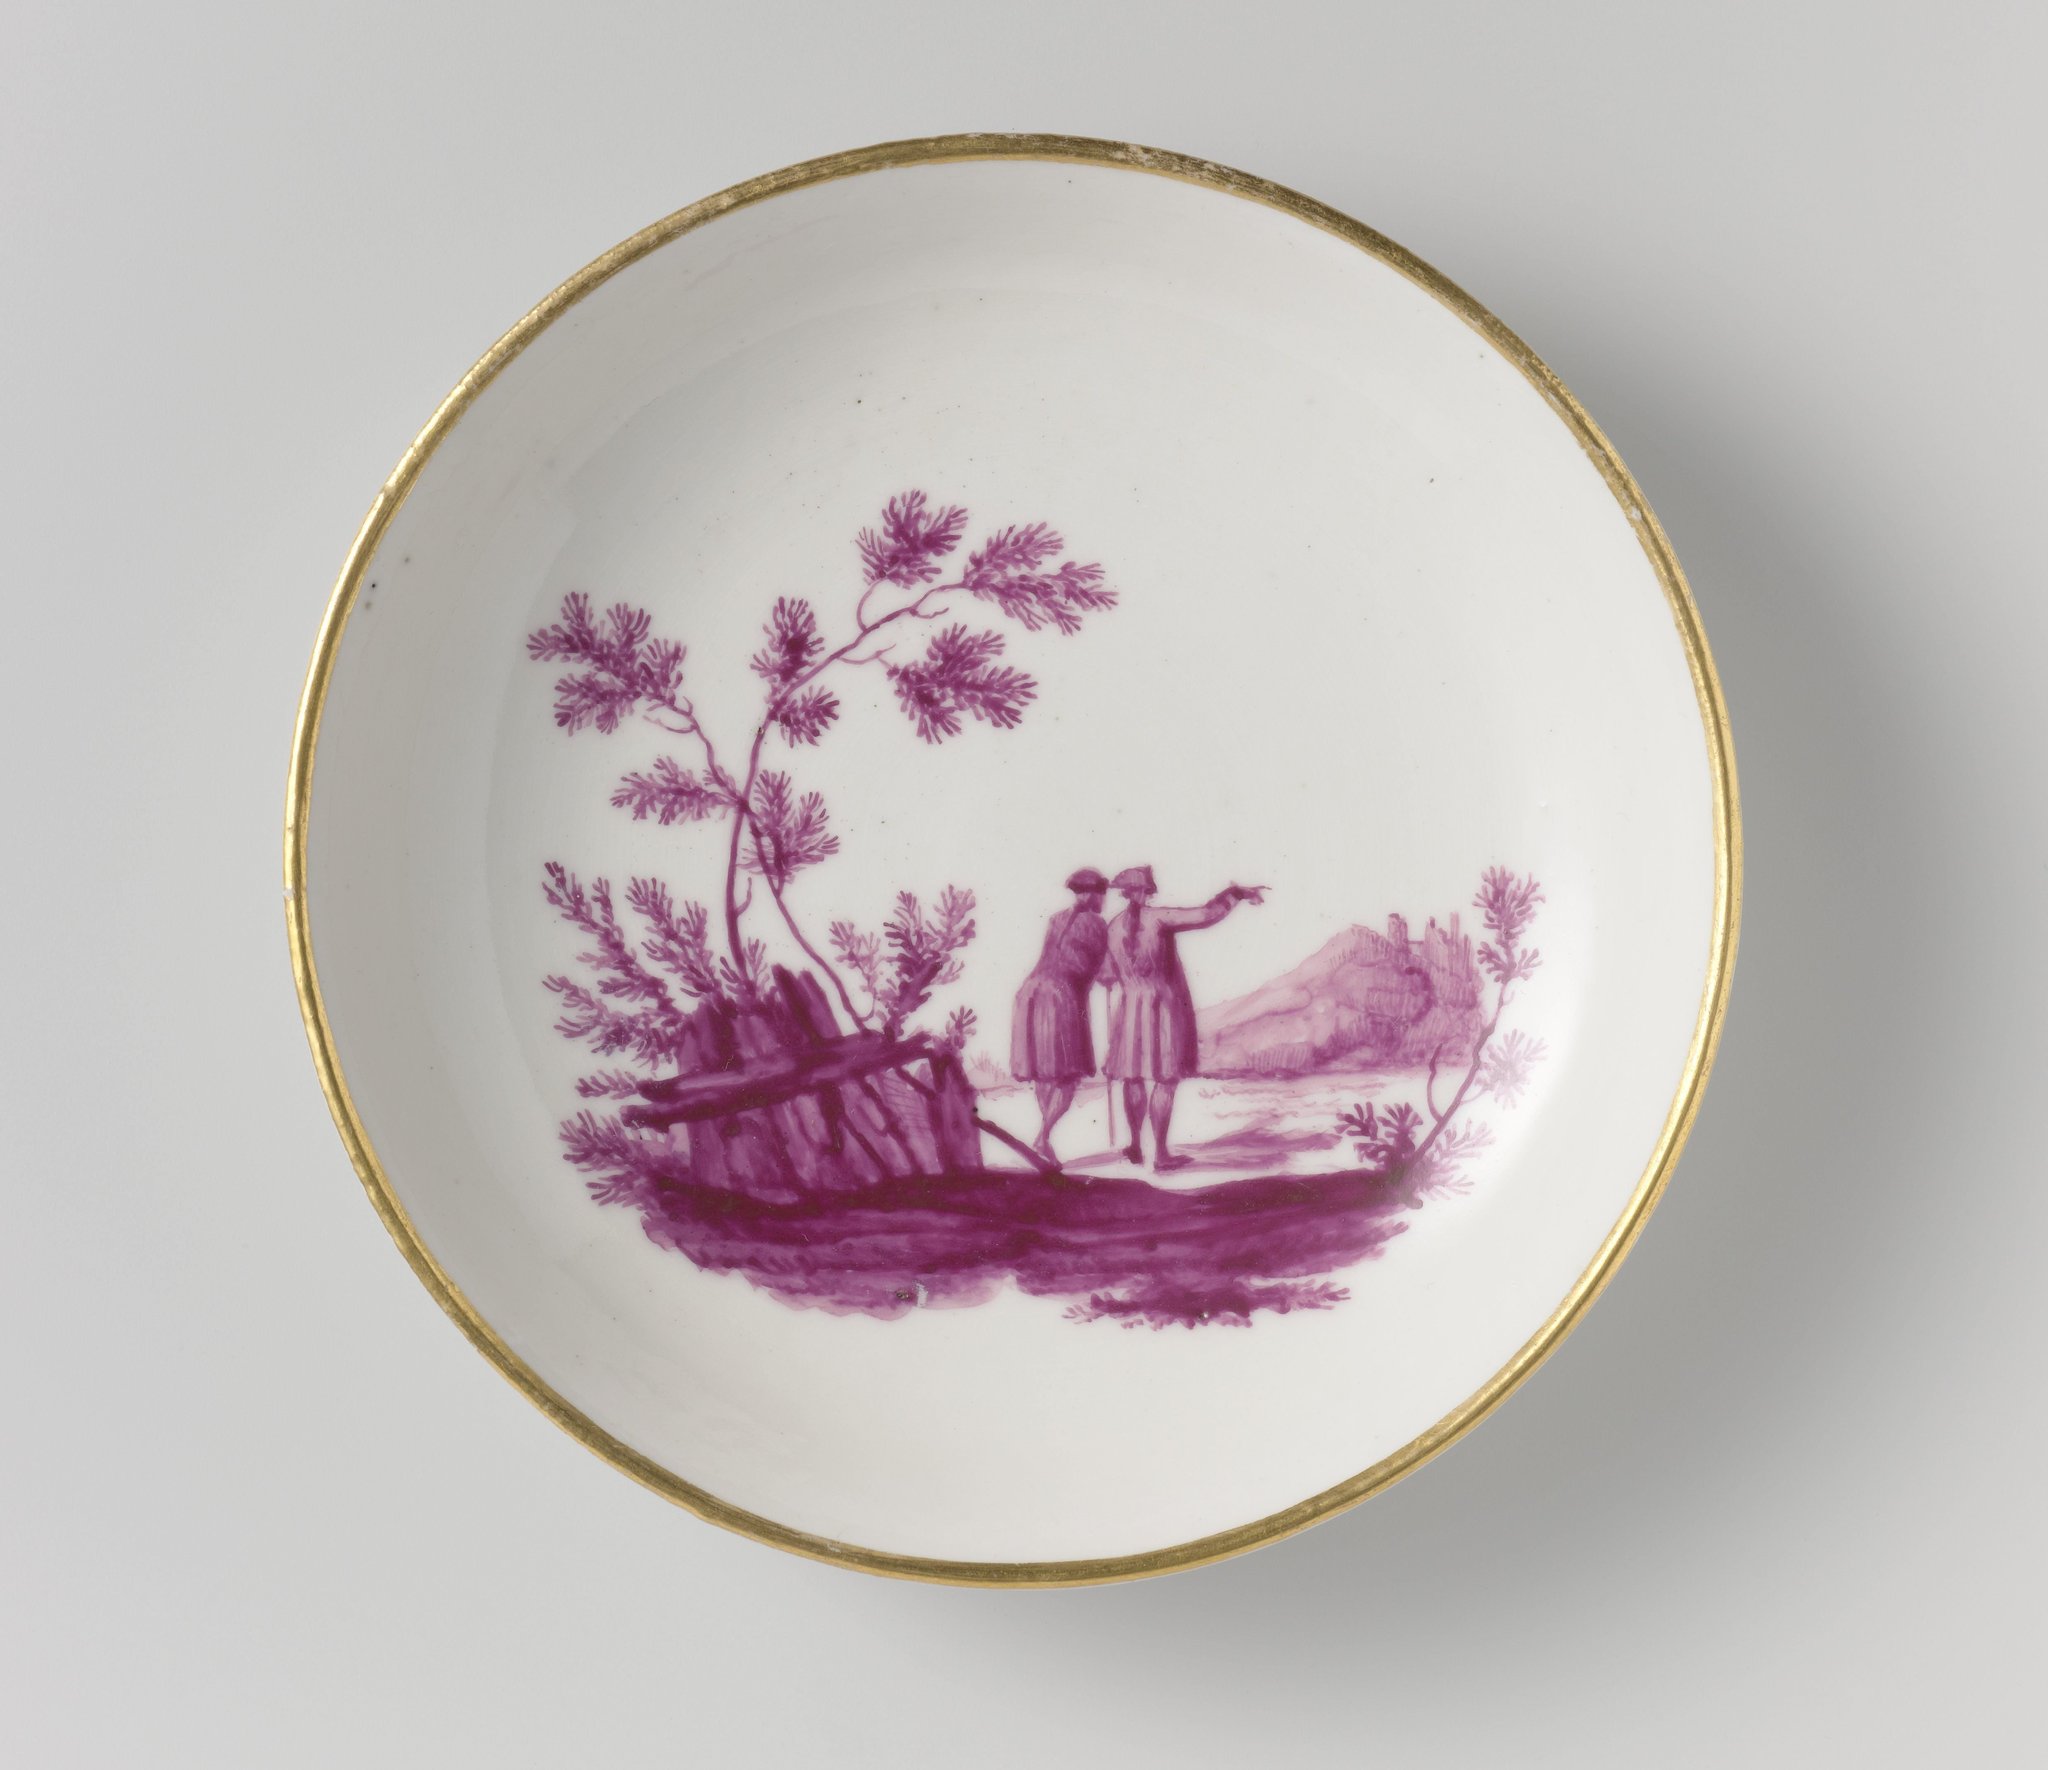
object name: platter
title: Schotel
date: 1775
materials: porcelain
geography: loosdrecht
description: Schotel van porselein. Onderdeel van een serie van twaafl stuks. Beschilderd met figuren in een landschap in bietenrood en gouden biezen.